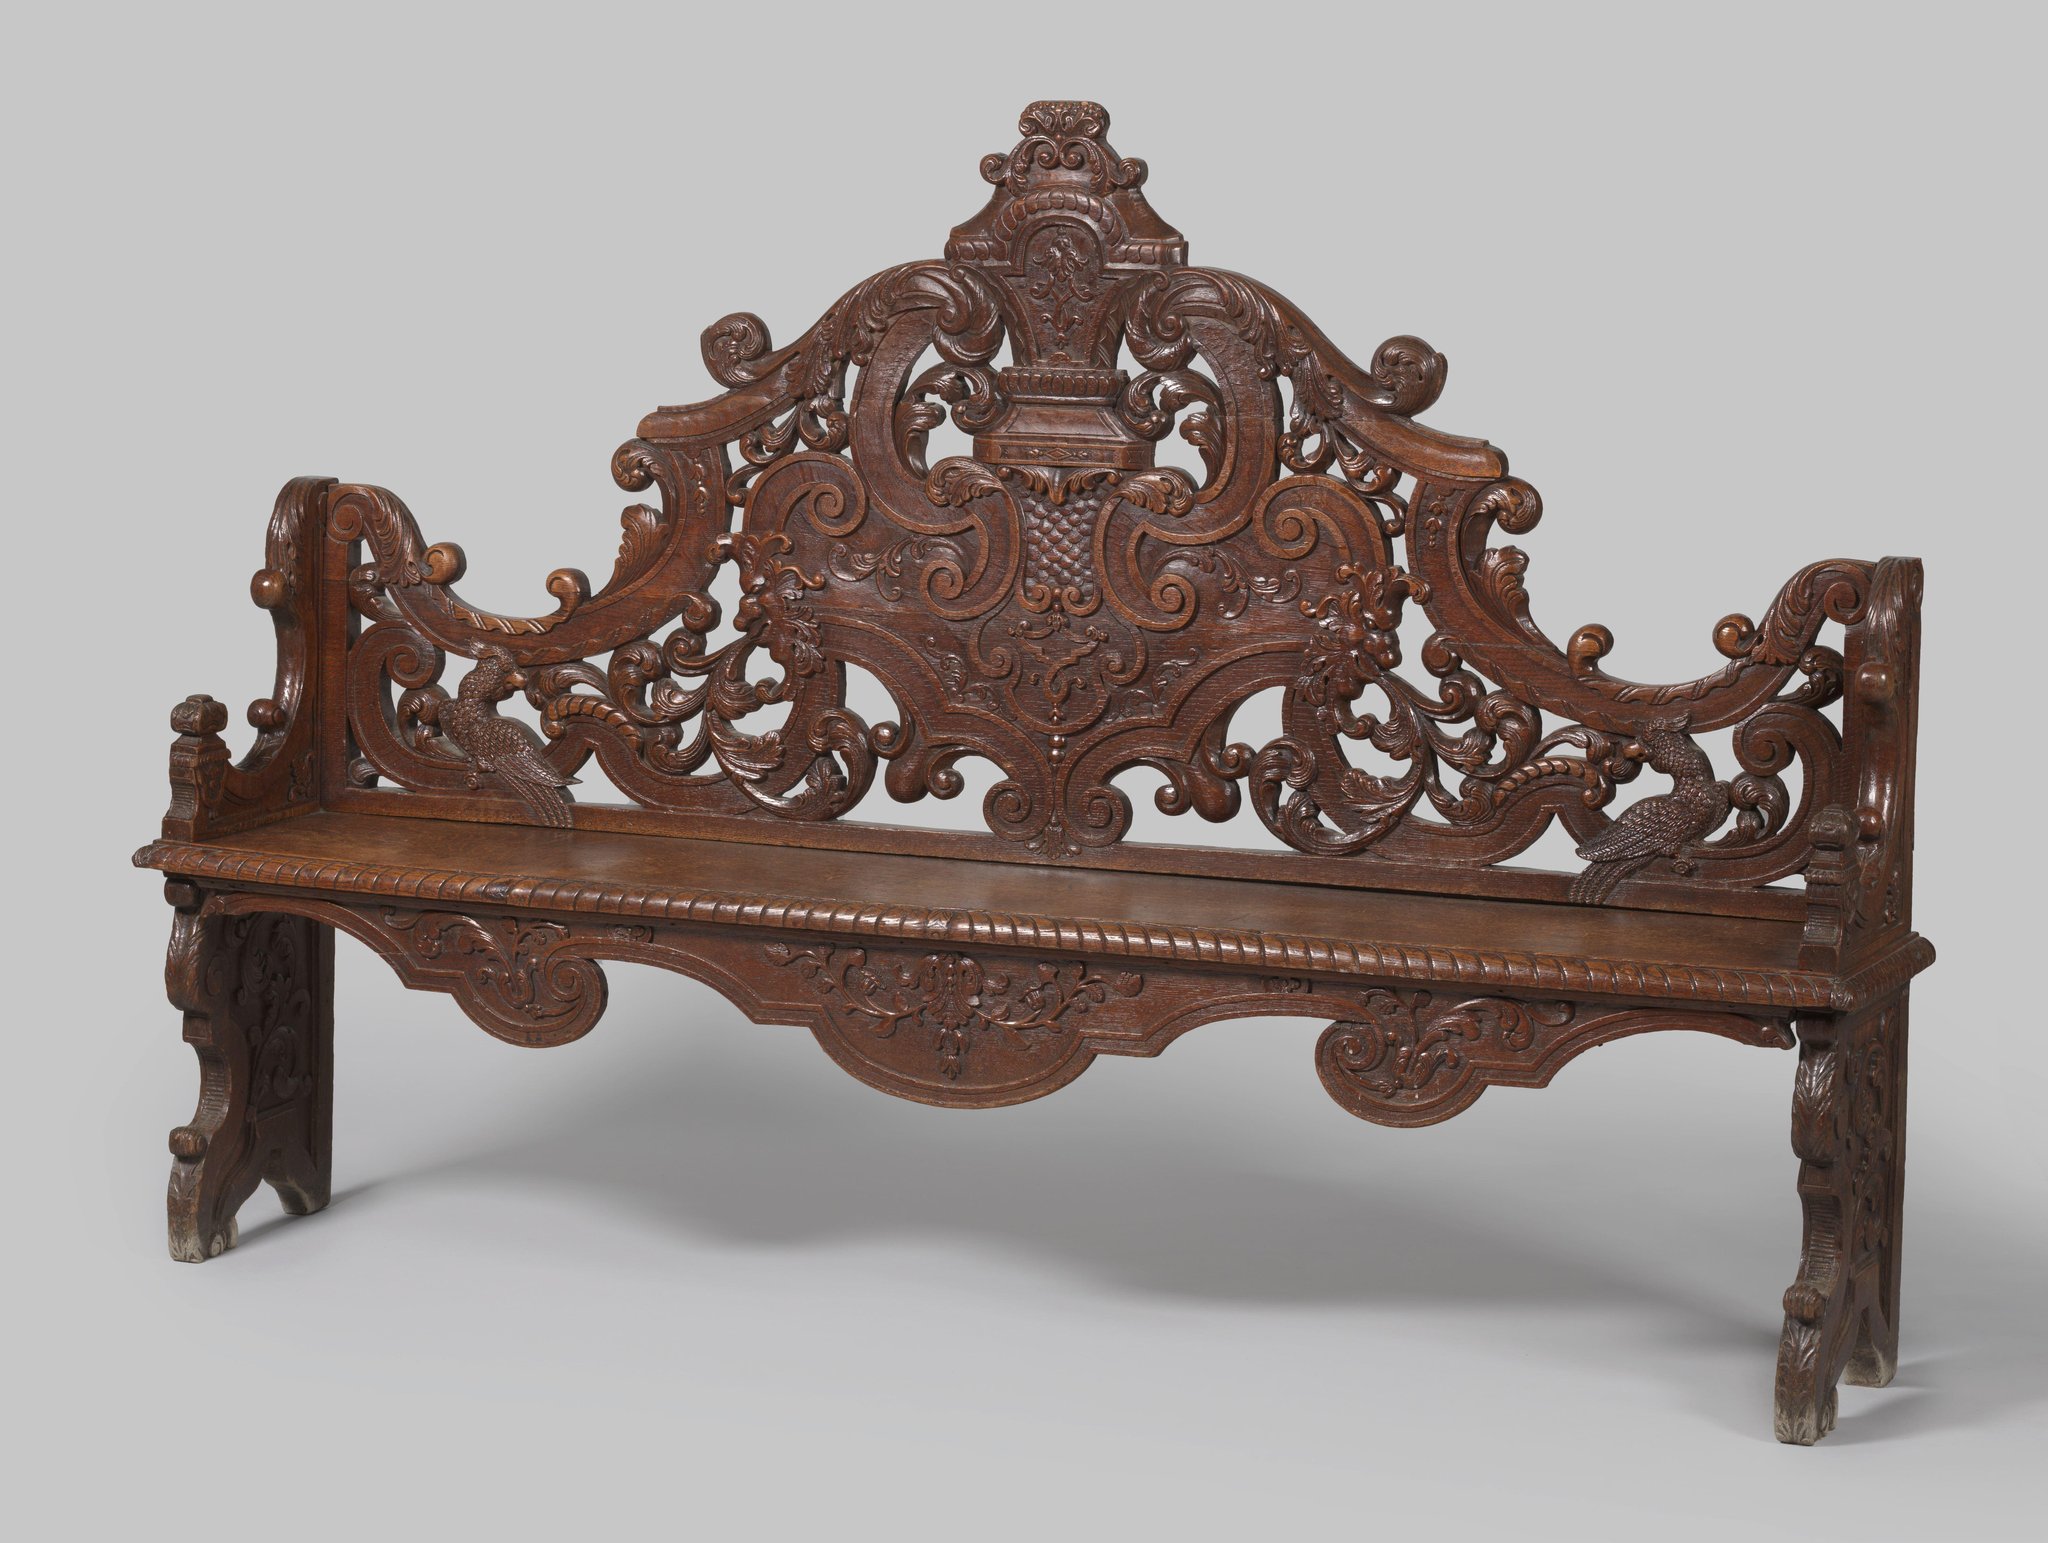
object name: furniture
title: Gangbank op wangen. Versierd met C- en S-voluten, vaas, maskers met acanthusvoluten, papegaaien, knorren en florale motieven.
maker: Anonymous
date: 1700-1725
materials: wood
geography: northern netherlands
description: Gangbank van eikenhout, gebeeldhouwd, rustend op wangen, die boven de zitting doorgetrokken zijn en overgaan in C-vormige armleggers. De opengewerkte rug heeft in het verhoogde middenstuk een vaas, temidden van gebroken S-voluten. De bovenkant van de rug loopt met C-voluten in de zijwangen over. Het middenstuk vertoont aan weerszijden maskers met acanthusvoluten en toegewende papegaaien. De zitting met rand van toegewende knorren. De geschulpte voorzitregel en schraagpoten zijn versierd met florale motieven.